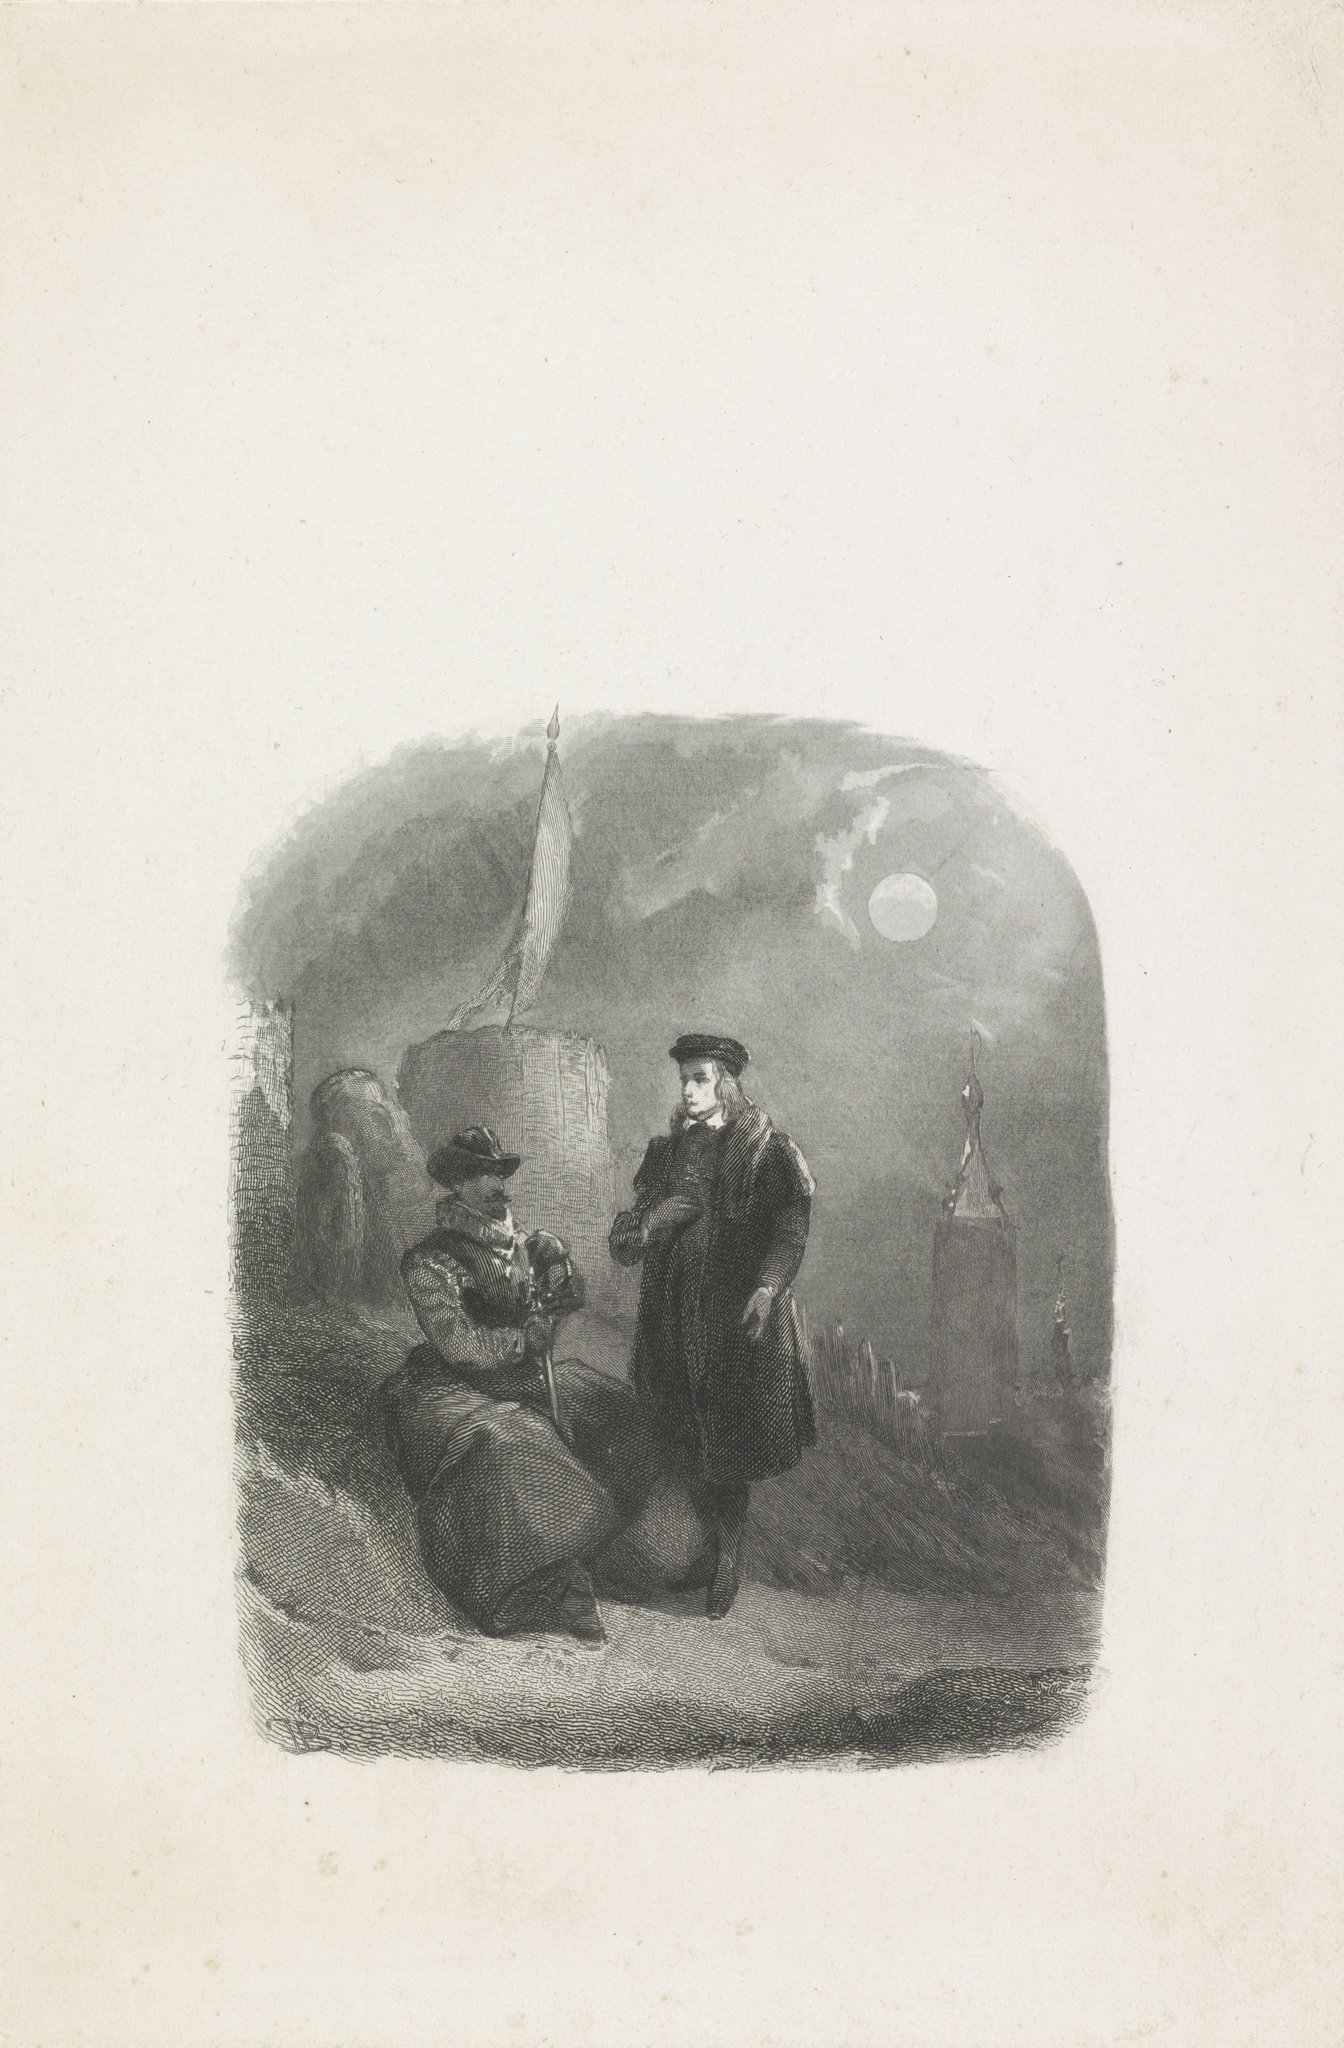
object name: print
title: Twee mannen bij maanlicht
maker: monogrammist jb (graveur)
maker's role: print maker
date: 1800-1906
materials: paper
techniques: etching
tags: moonlight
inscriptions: collector's mark: Lugt 2228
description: Links een zittende man met hoed op het hoofd, leunend op een geweer. Hij kijkt op naar de staande man rechts. Op de achtergrond een toren. Aan de hemel de maan.